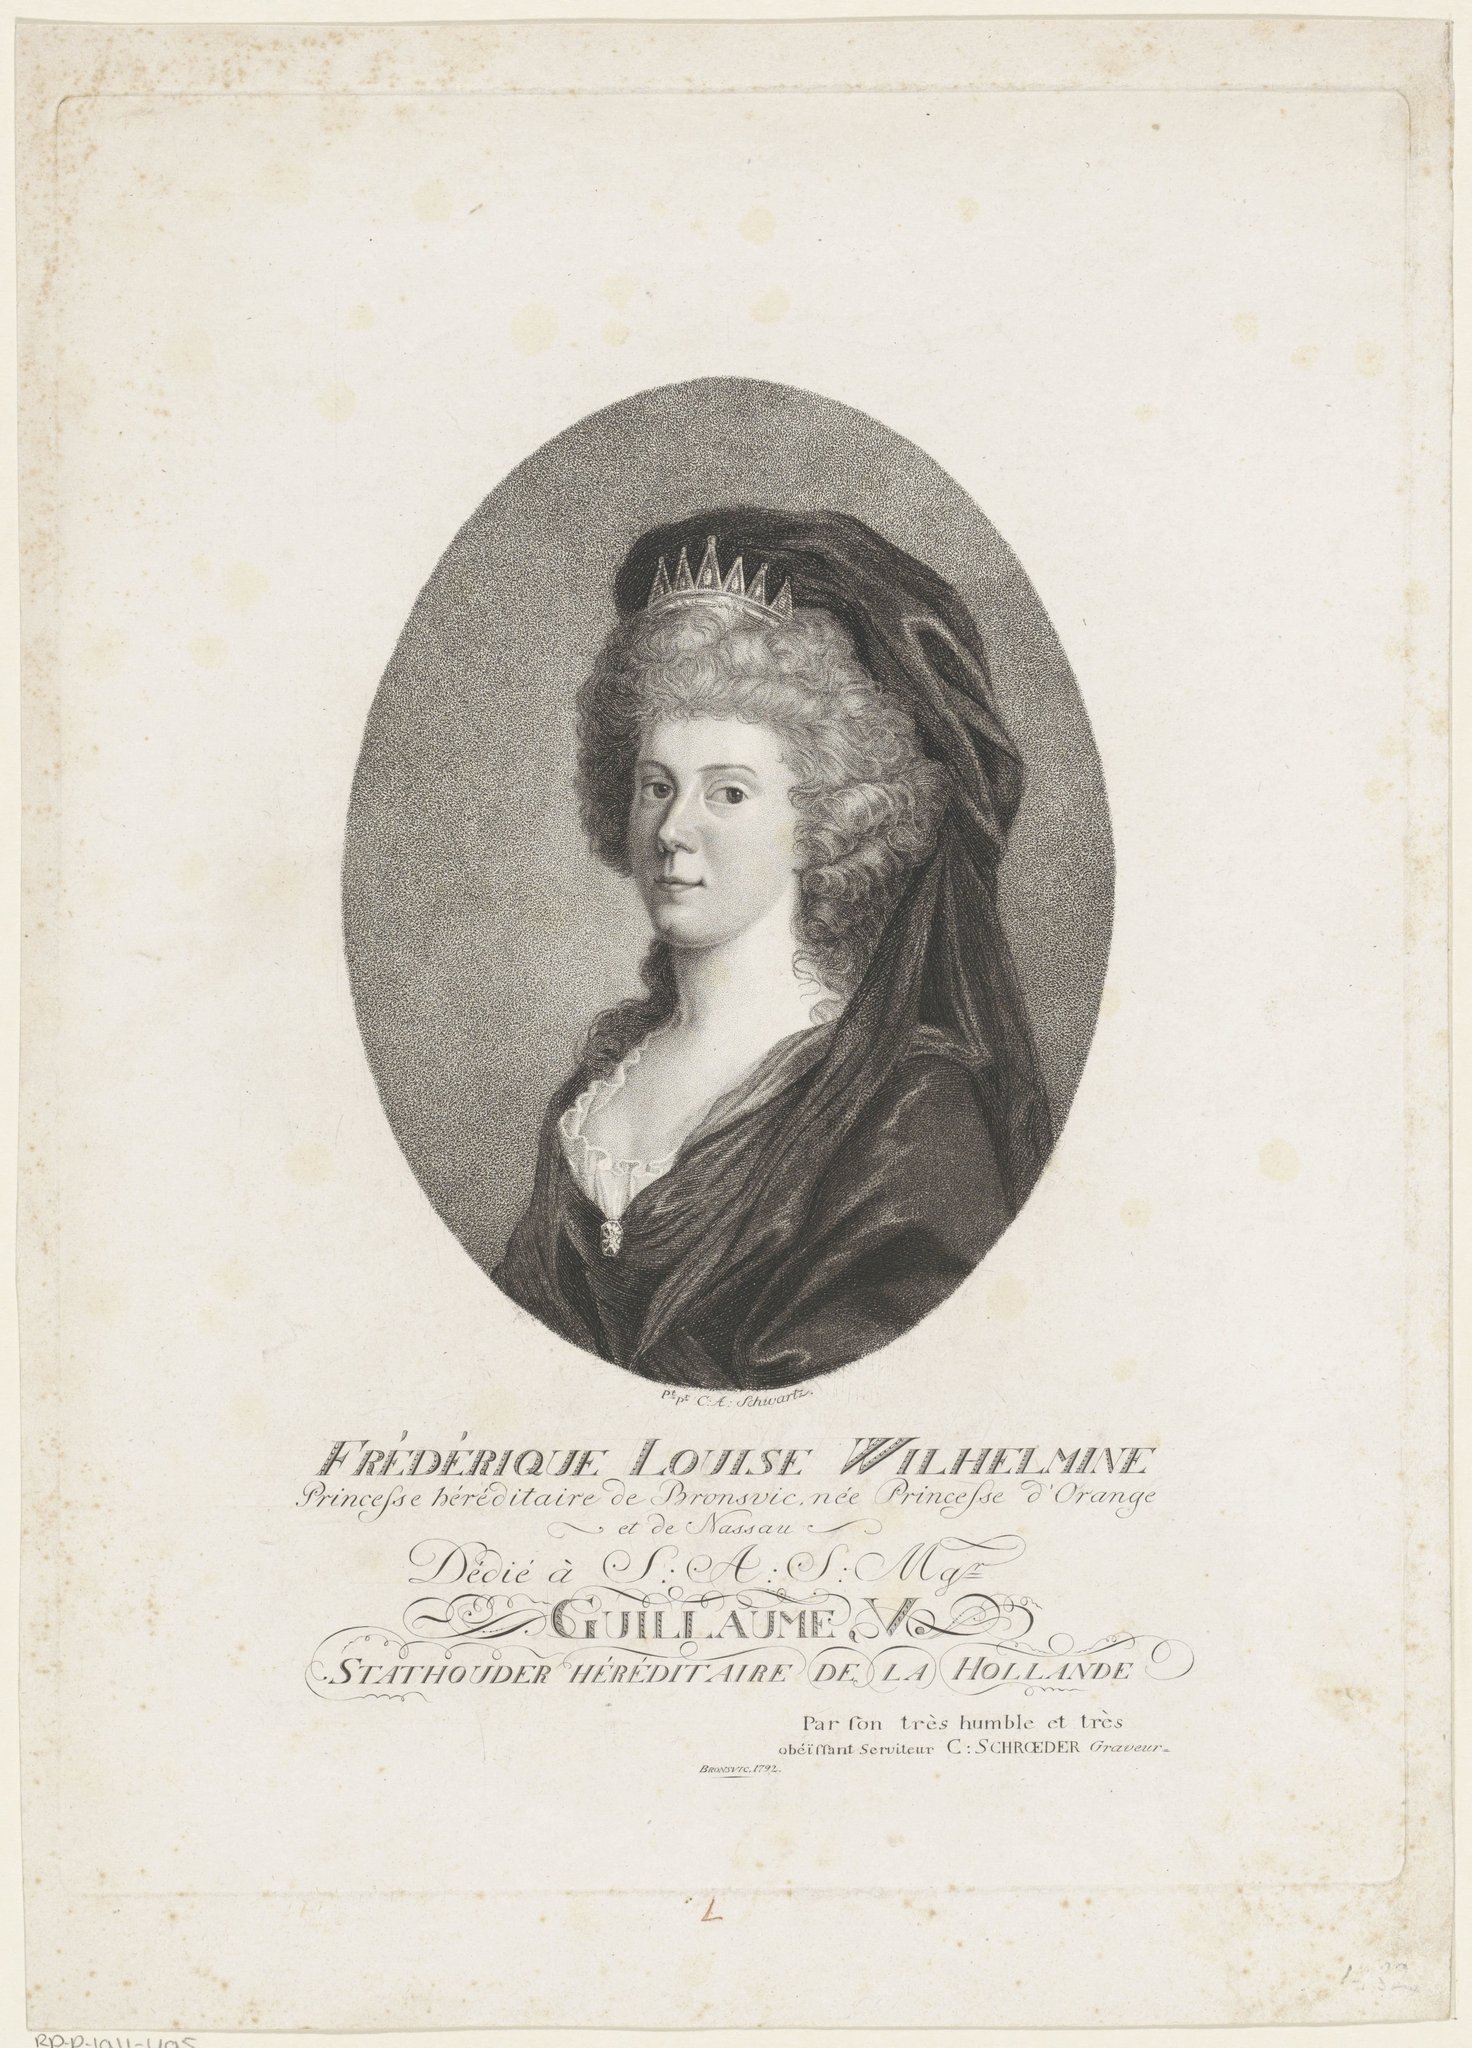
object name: print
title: Portret van Louise, prinses van Oranje-Nassau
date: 1792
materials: paper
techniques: engraving, etching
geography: braunschweig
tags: the hague, amsterdam, louise (prinses van oranje-nassau)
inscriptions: collector's mark: Lugt 2228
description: De hier vermelde titel verwijst naar de hoogst verkregen titel van de geportretteerde, niet per se naar de titel die de geportretteerde op deze voorstelling draagt.